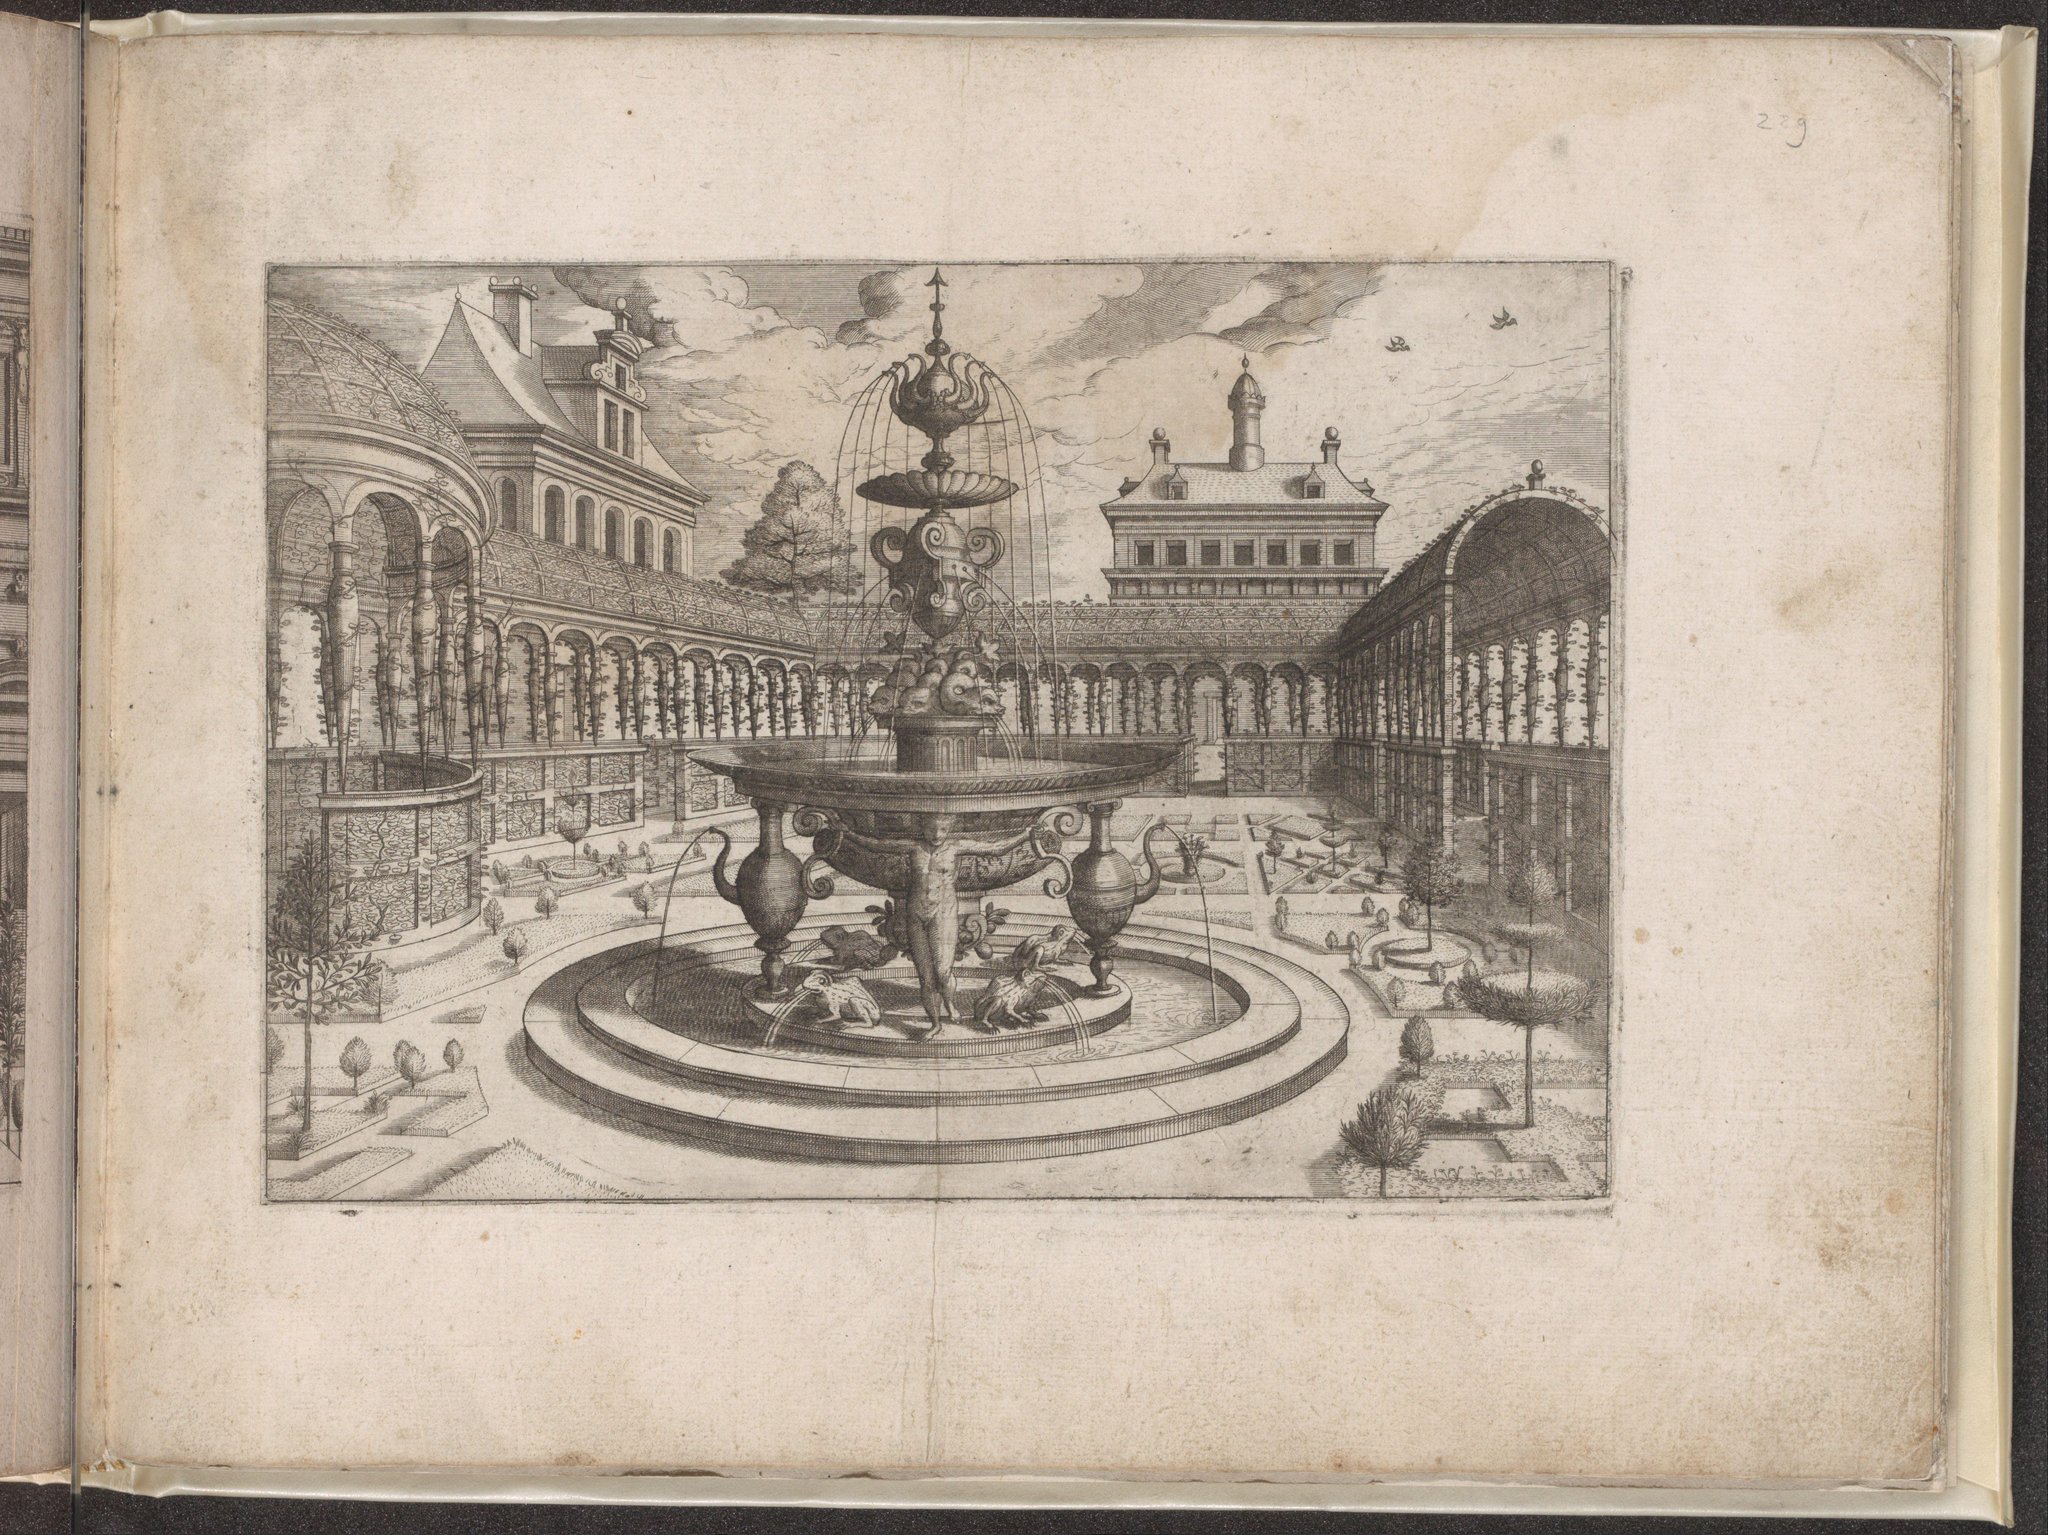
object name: album leaf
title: Paleistuin met een ronde fontein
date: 1568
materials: paper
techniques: etching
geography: antwerp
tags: piece of sculpture, reproduction of a piece of sculpture, courtyard, ornamental fountain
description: Paleistuin met een fontein met een rond bassin dat wordt gedragen door vazen en een staande naakte man. Onderaan vier waterspuwende kikkers. Rond de tuin gangen van traliewerk. Deze prent maakt deel uit van een album.